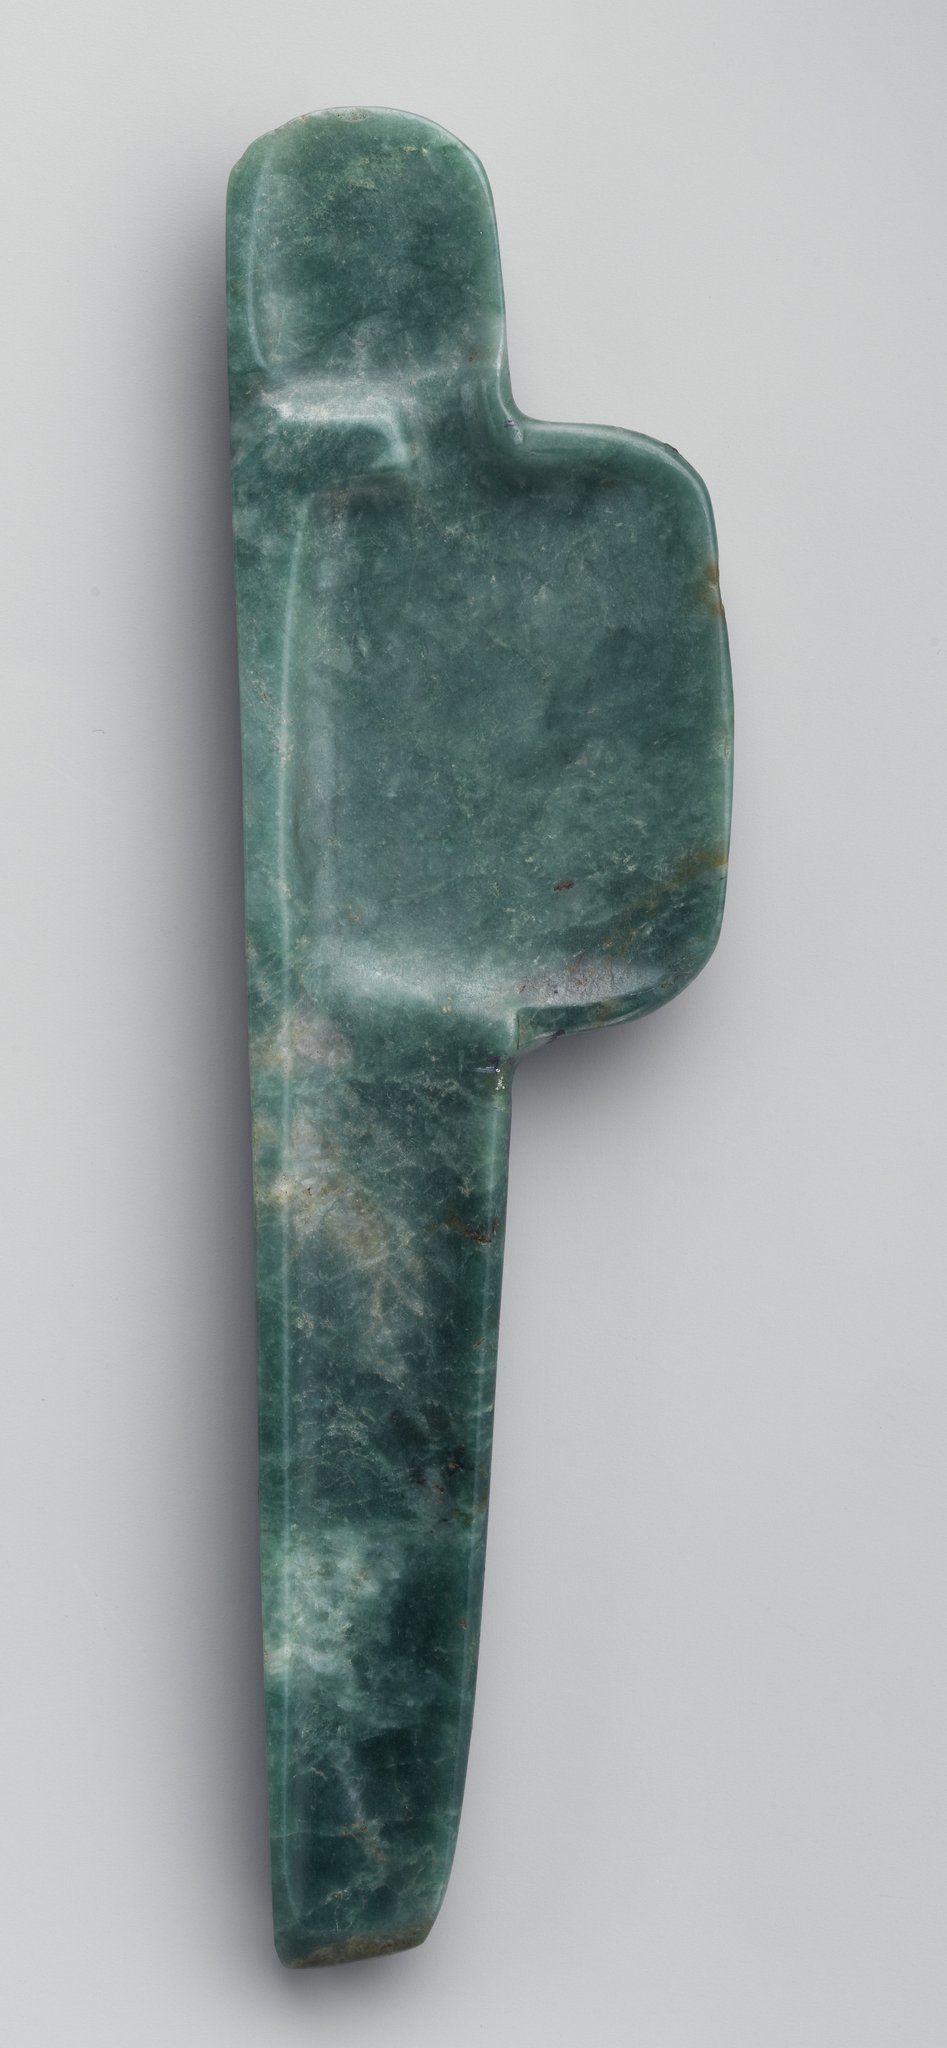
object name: pendant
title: Ritual object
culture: olmec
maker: olmec artist(s)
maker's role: artist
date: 900-400 BCE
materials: jade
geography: mexico